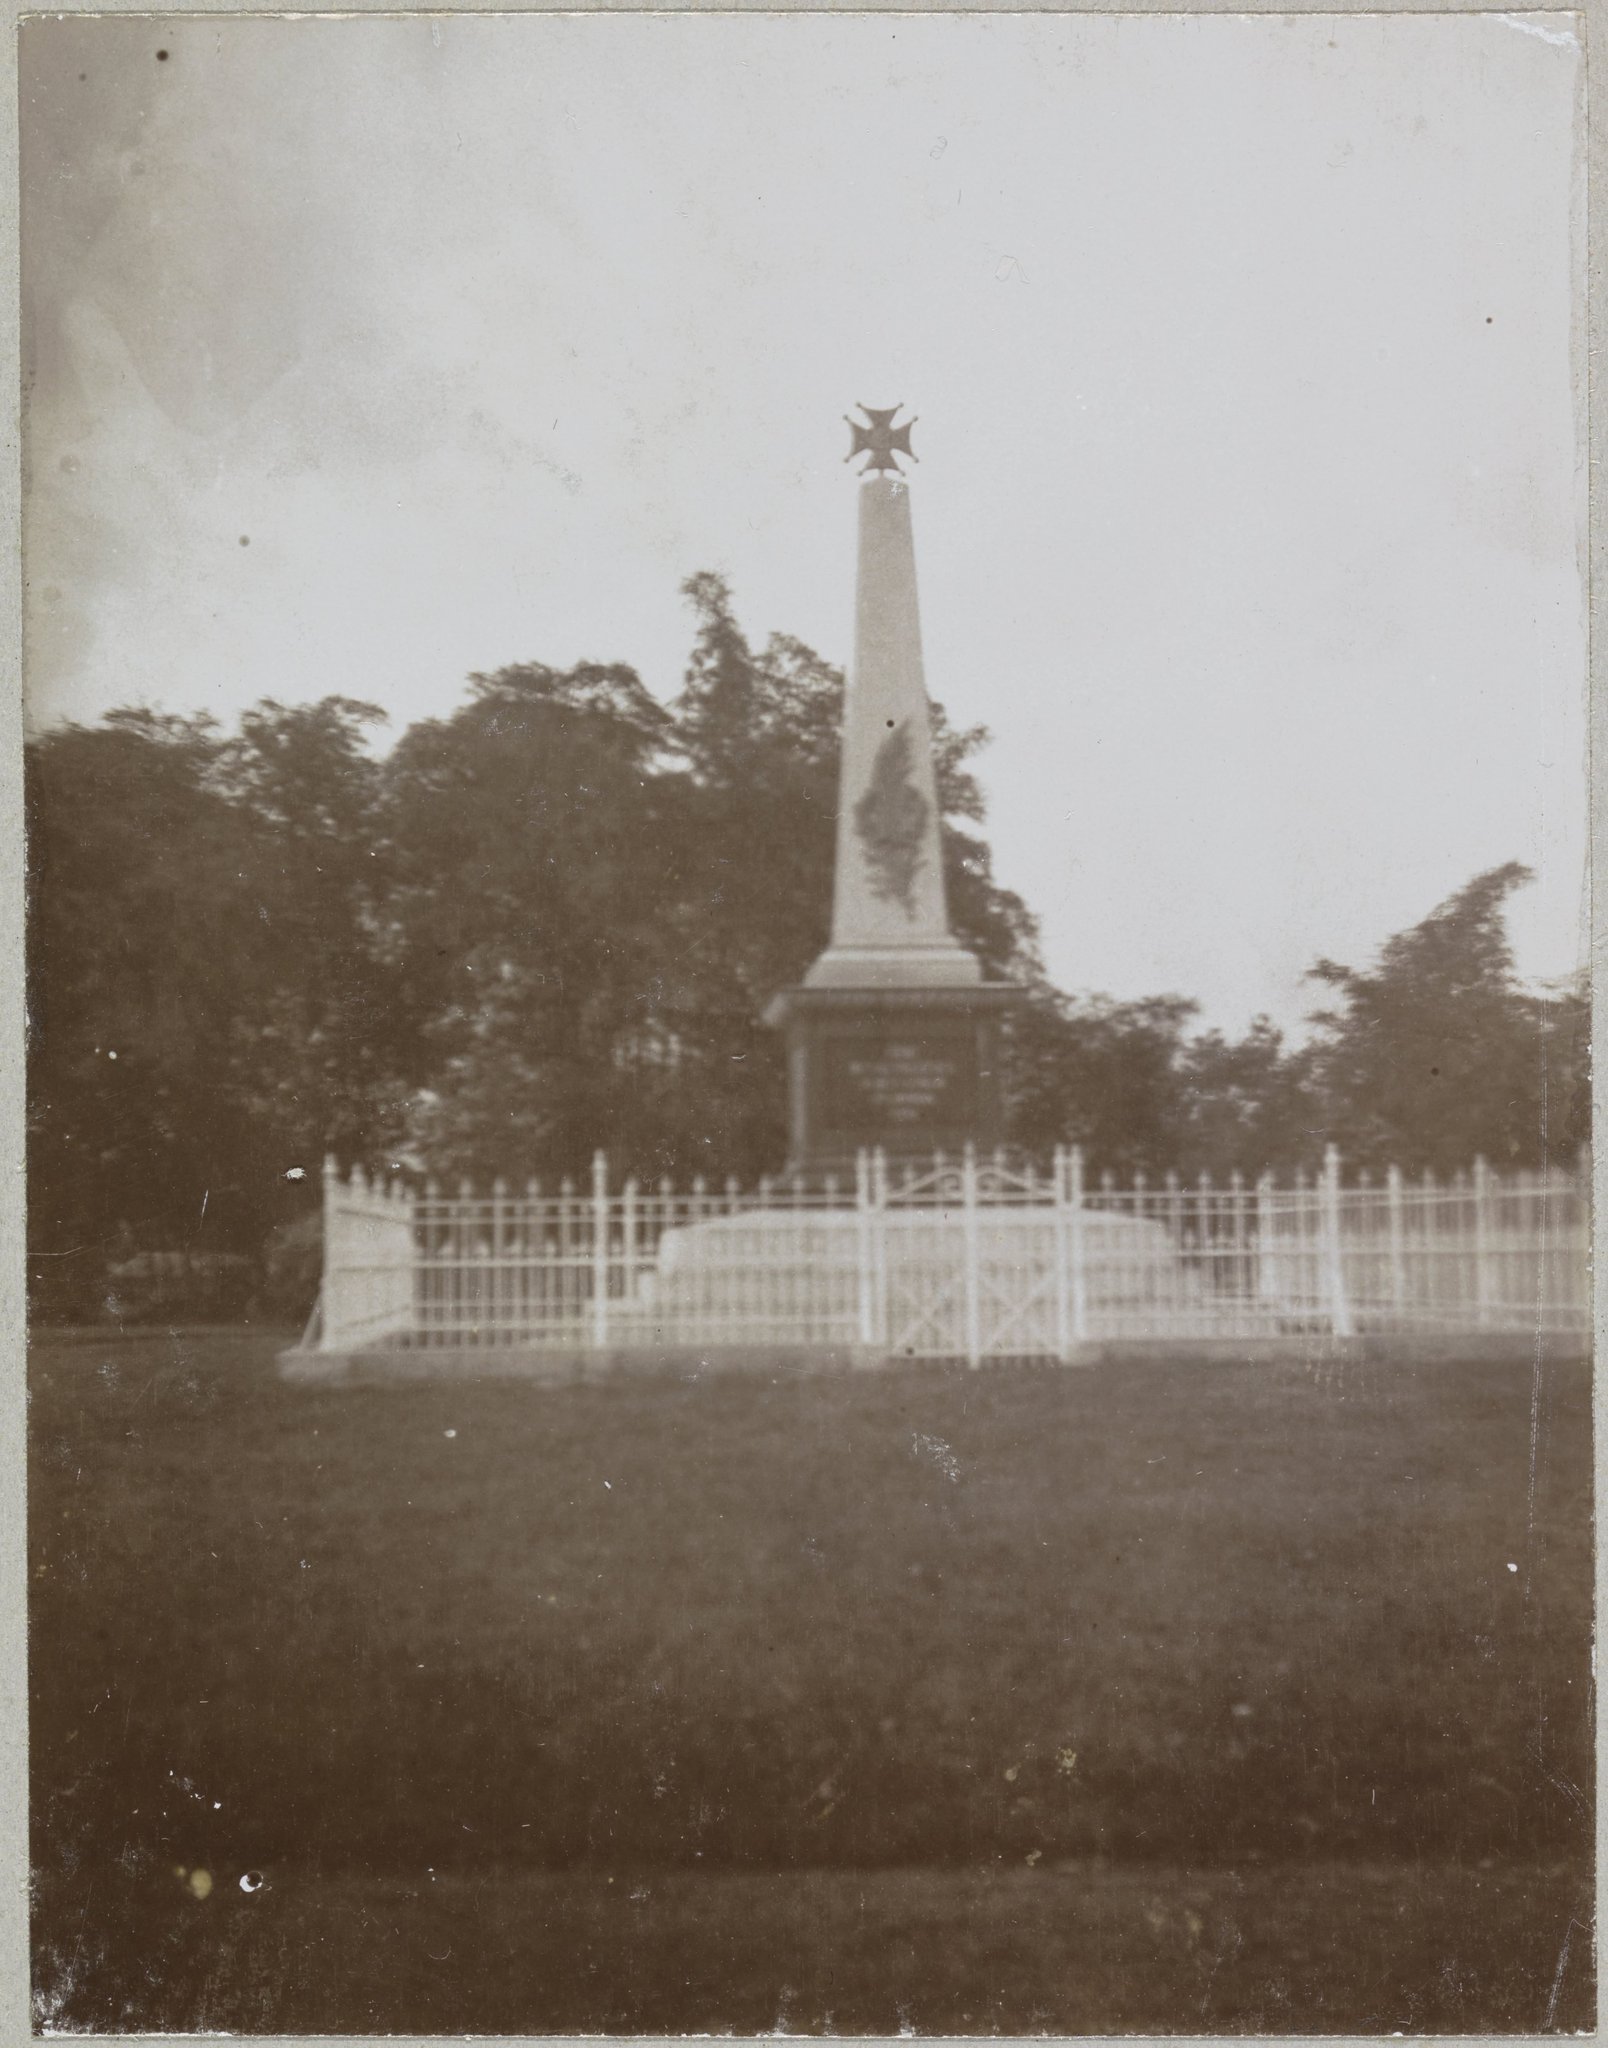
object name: photograph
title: Gedenkteken van 1894, Mataram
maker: Anonymous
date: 1895-1915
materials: cardboard, paper, photographic support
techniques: collodion silver print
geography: mataram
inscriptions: annotation: ‘2) gedenkteken van 1894 te Mataram (Lombok)’